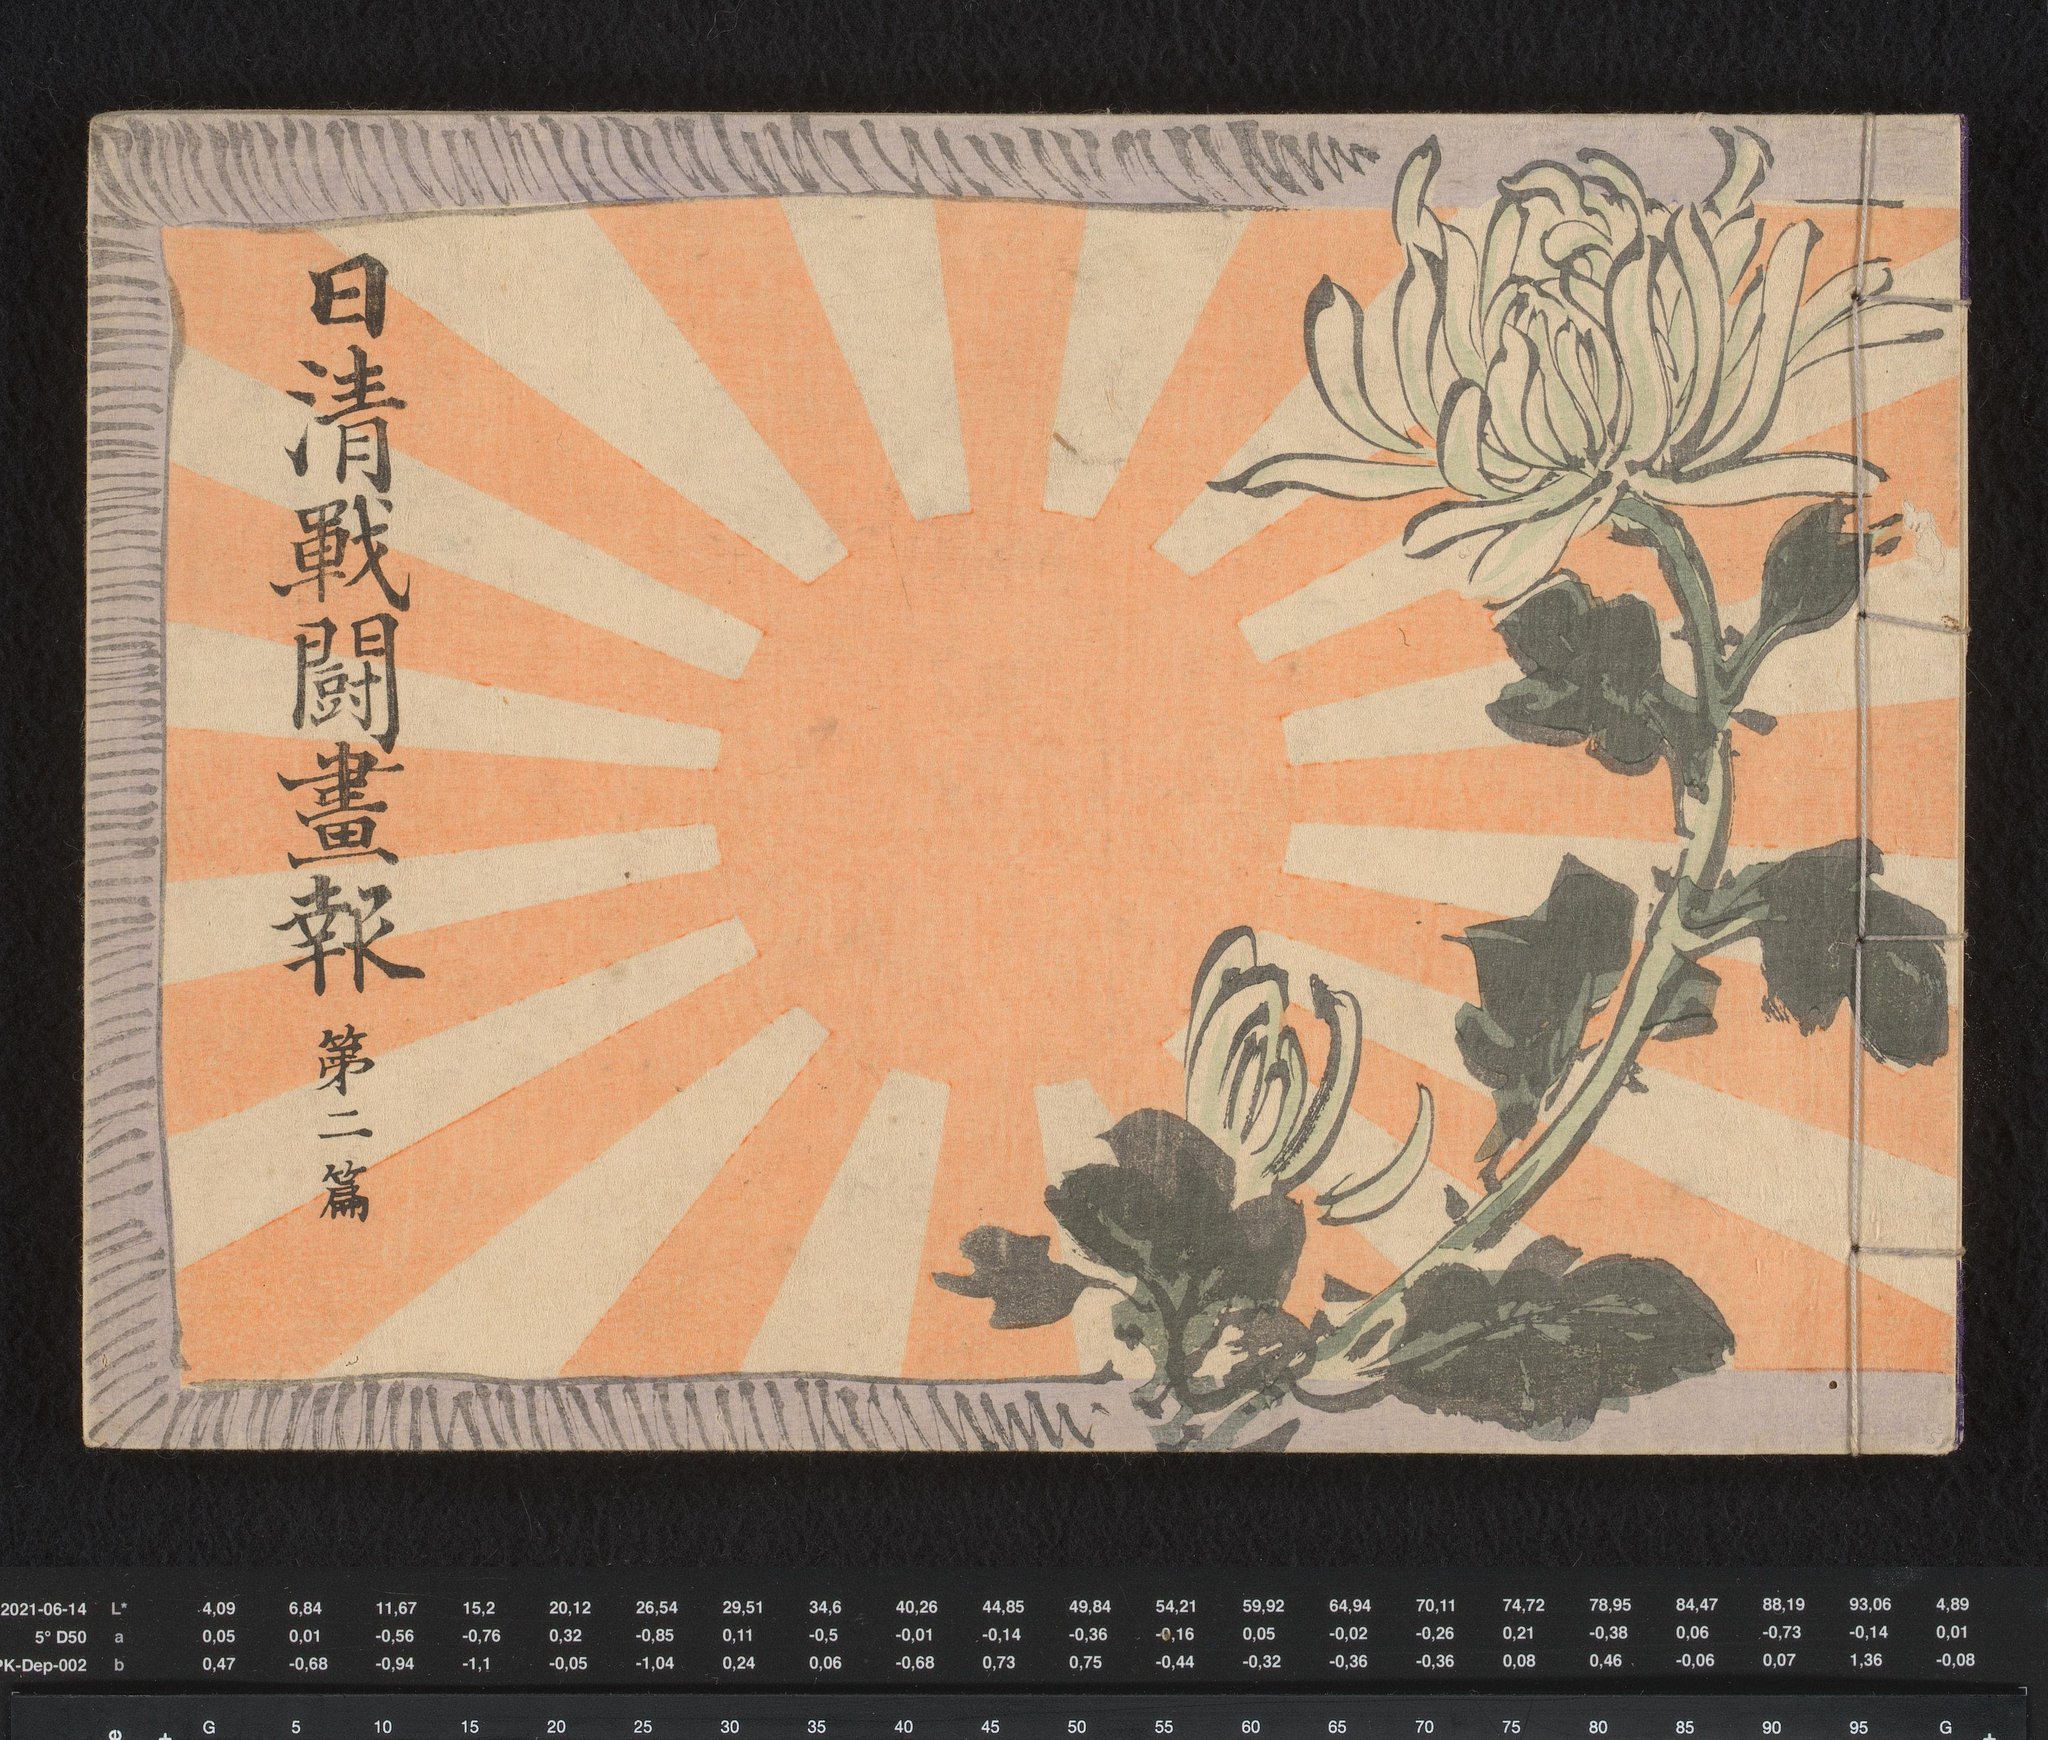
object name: book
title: Nisshin sento gaho dai nipen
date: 1811-1894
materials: paper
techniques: woodcut, letterpress printing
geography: taiwan strait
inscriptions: date